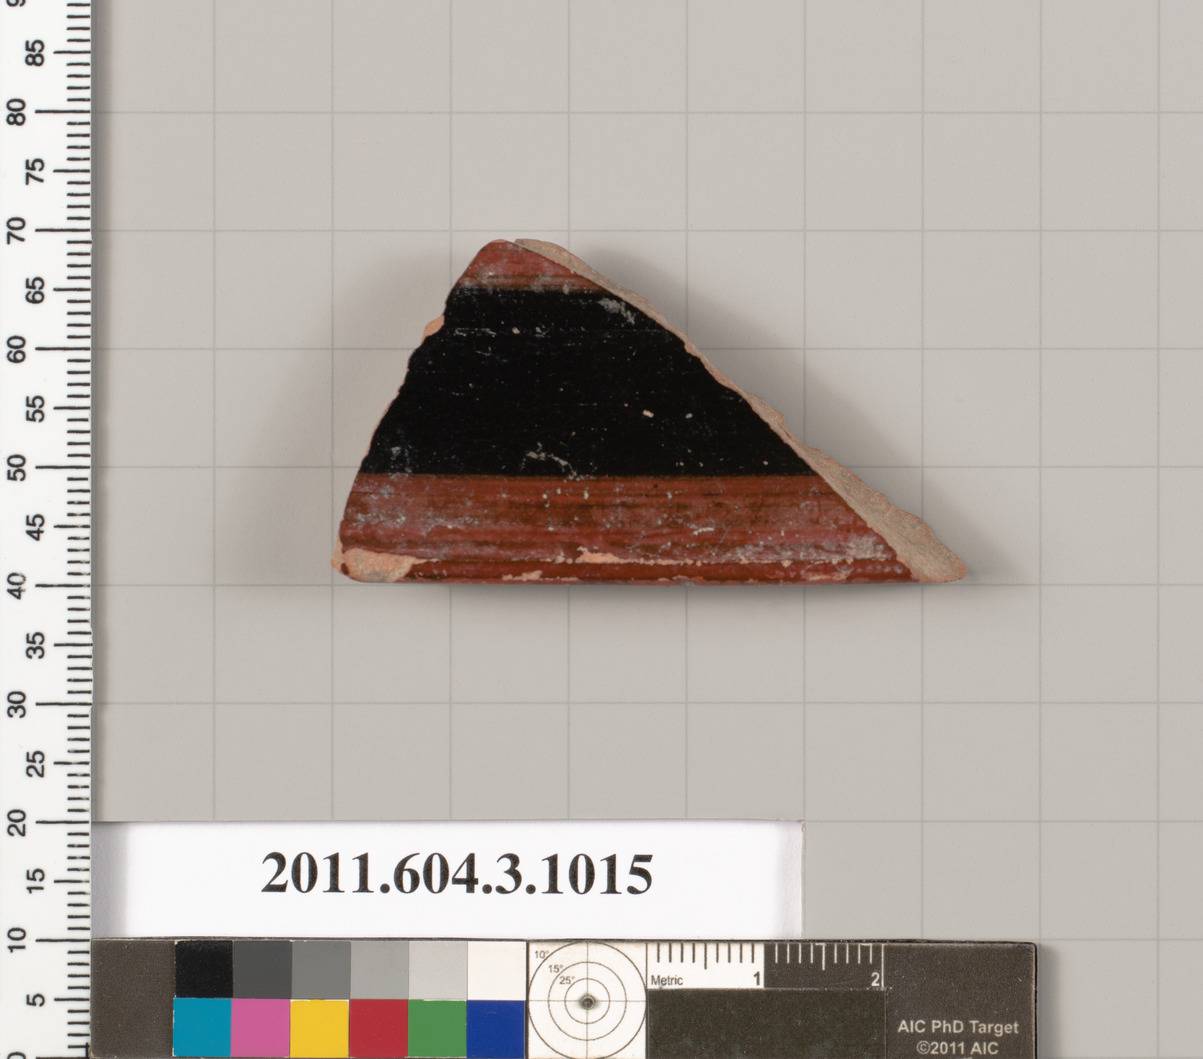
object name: lekanis fragment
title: Terracotta fragment of a lekanis (covered dish)?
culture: greek, attic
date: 600-501 BCE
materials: terracotta